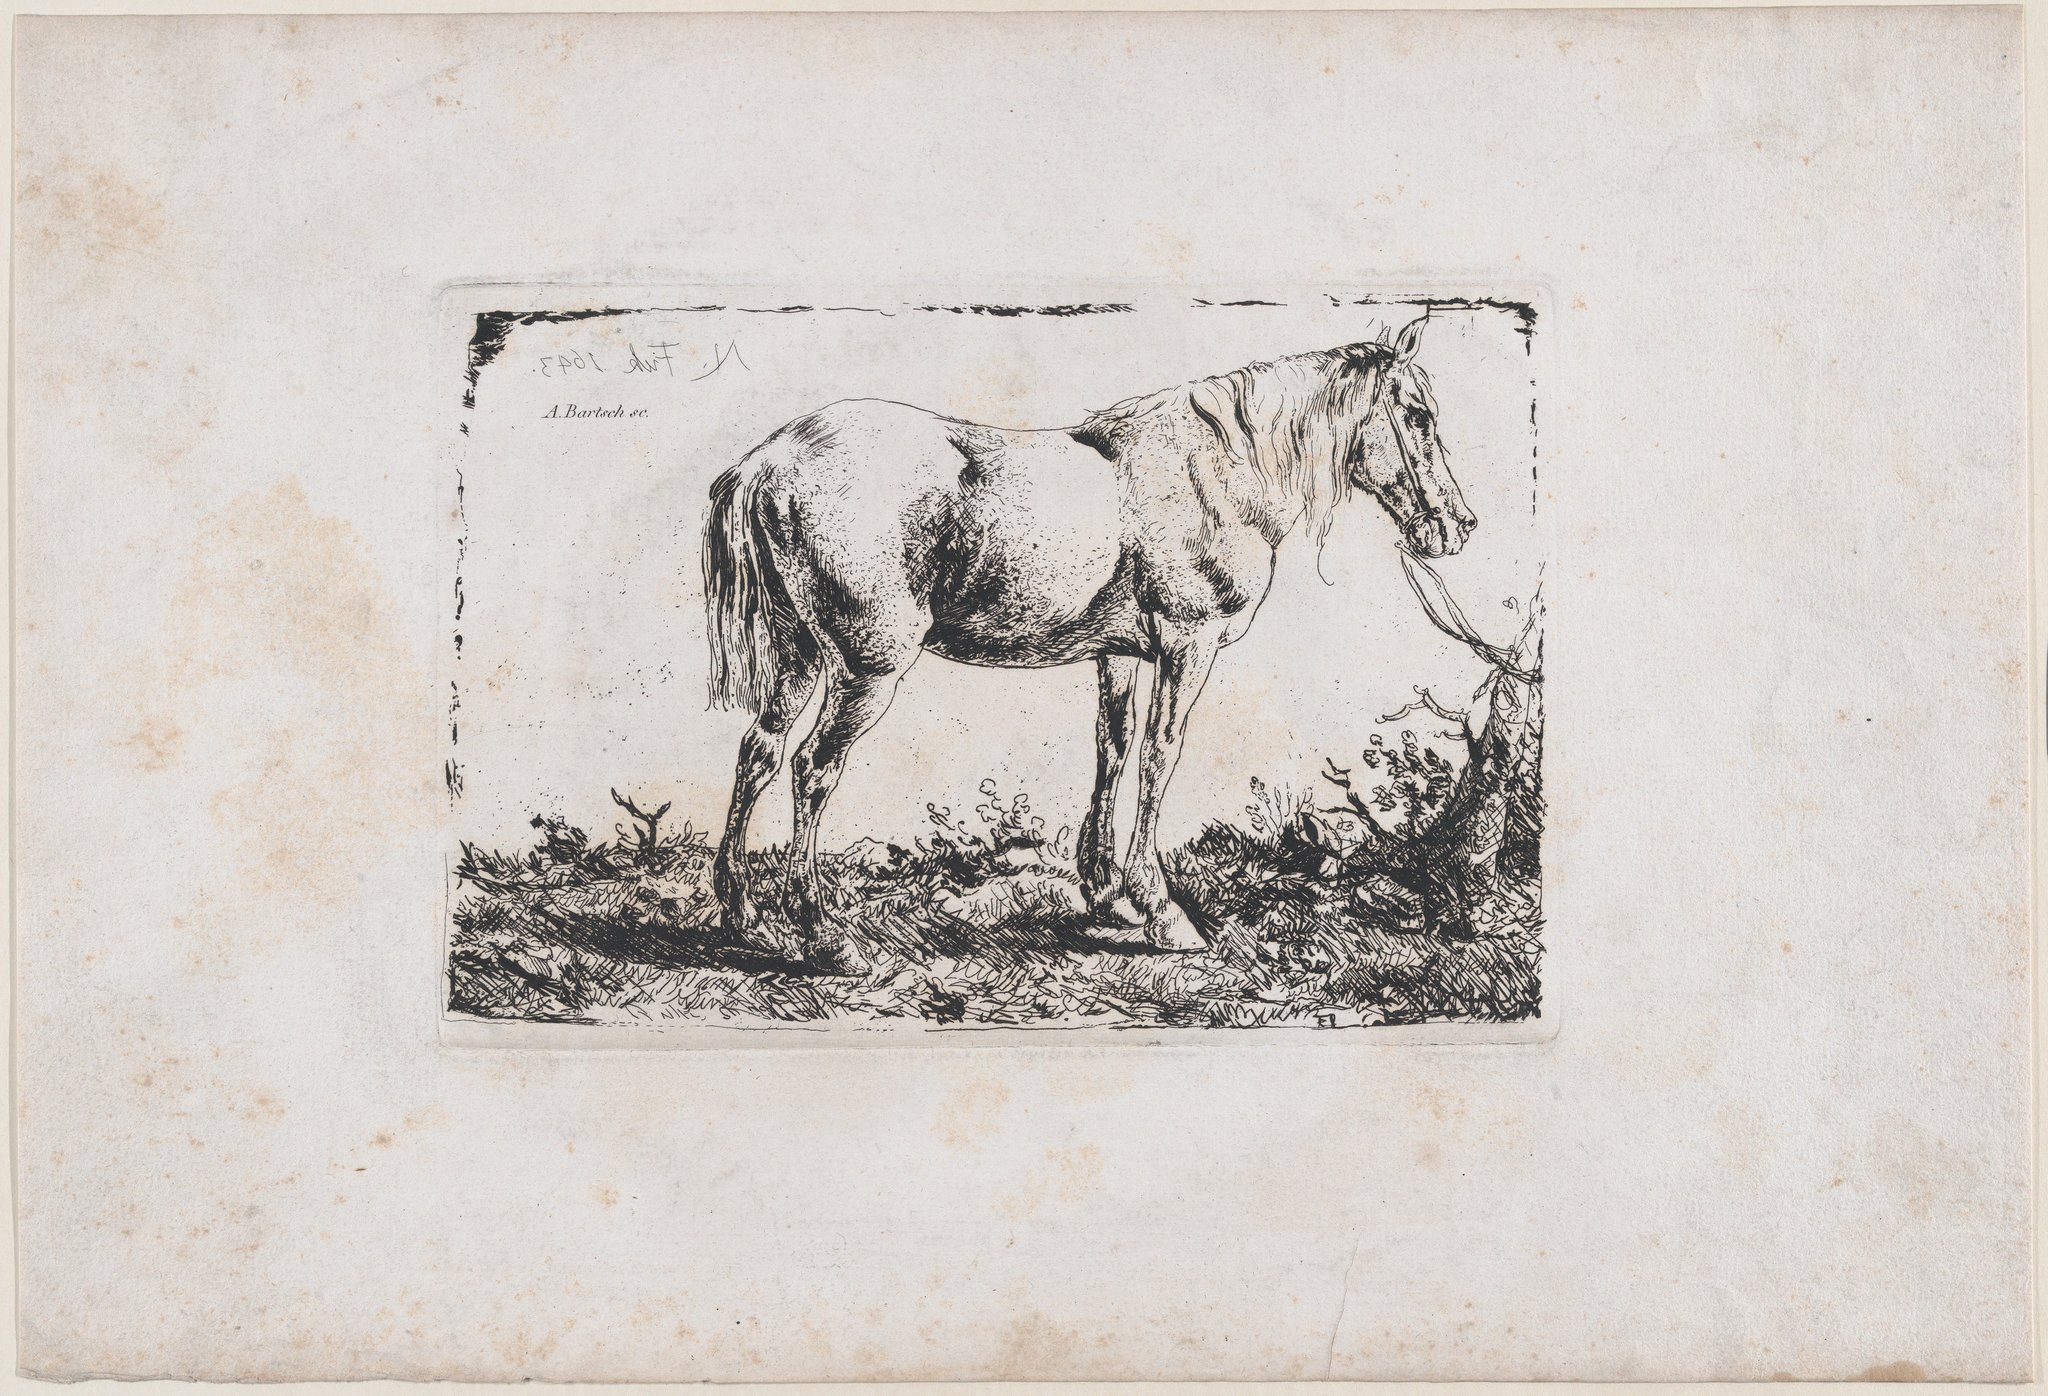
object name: print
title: Horse Standing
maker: adam von bartsch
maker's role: artist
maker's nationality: austrian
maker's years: 1757-1821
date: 1803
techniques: etching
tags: horses